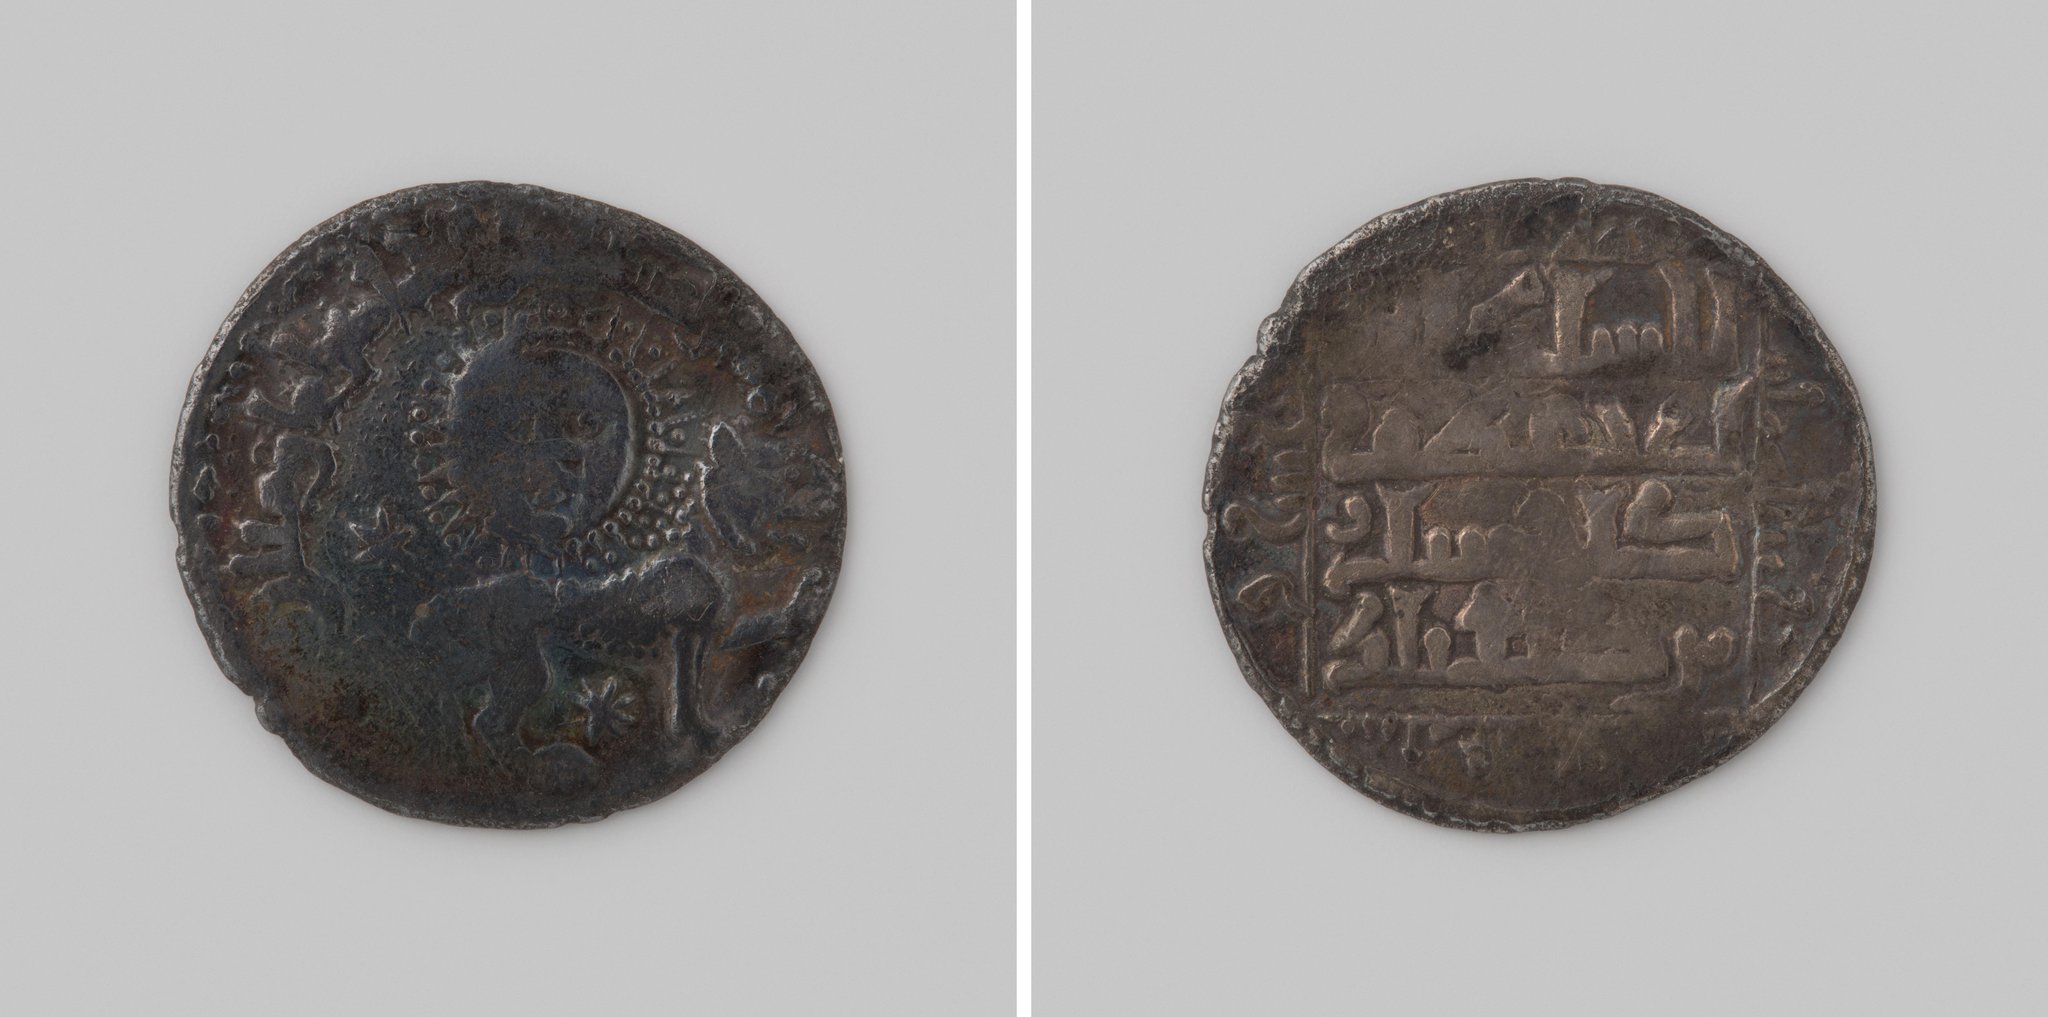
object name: coin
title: Dirhem van de Seldsjoeken van Rum van sultan Ghiyas ed-din Kai-Khusru I, 634-643 AH [=1192-1200]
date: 1192-1200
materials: silver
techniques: striking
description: Zilveren munt. Voorzijde: lopende leeuw naar rechts, waarboven zon [=sterrebeeld van de echtgenote van de sultan]. Omschrift in Arabische lettertekenss. Keerzijde: binnen vierkant opschrift in Arabische lettertekens, in Koefisch schrift, in vier regels. Rondom vierkant opschrift in Arabische lettertekens.